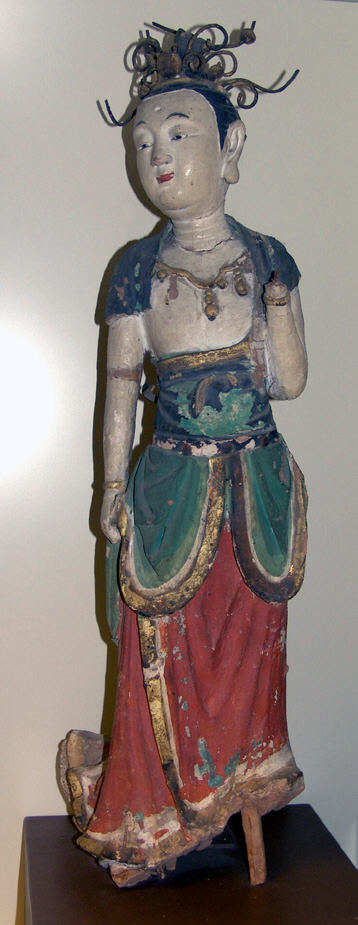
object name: statuette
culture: chinese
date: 1644-1911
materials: mud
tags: women